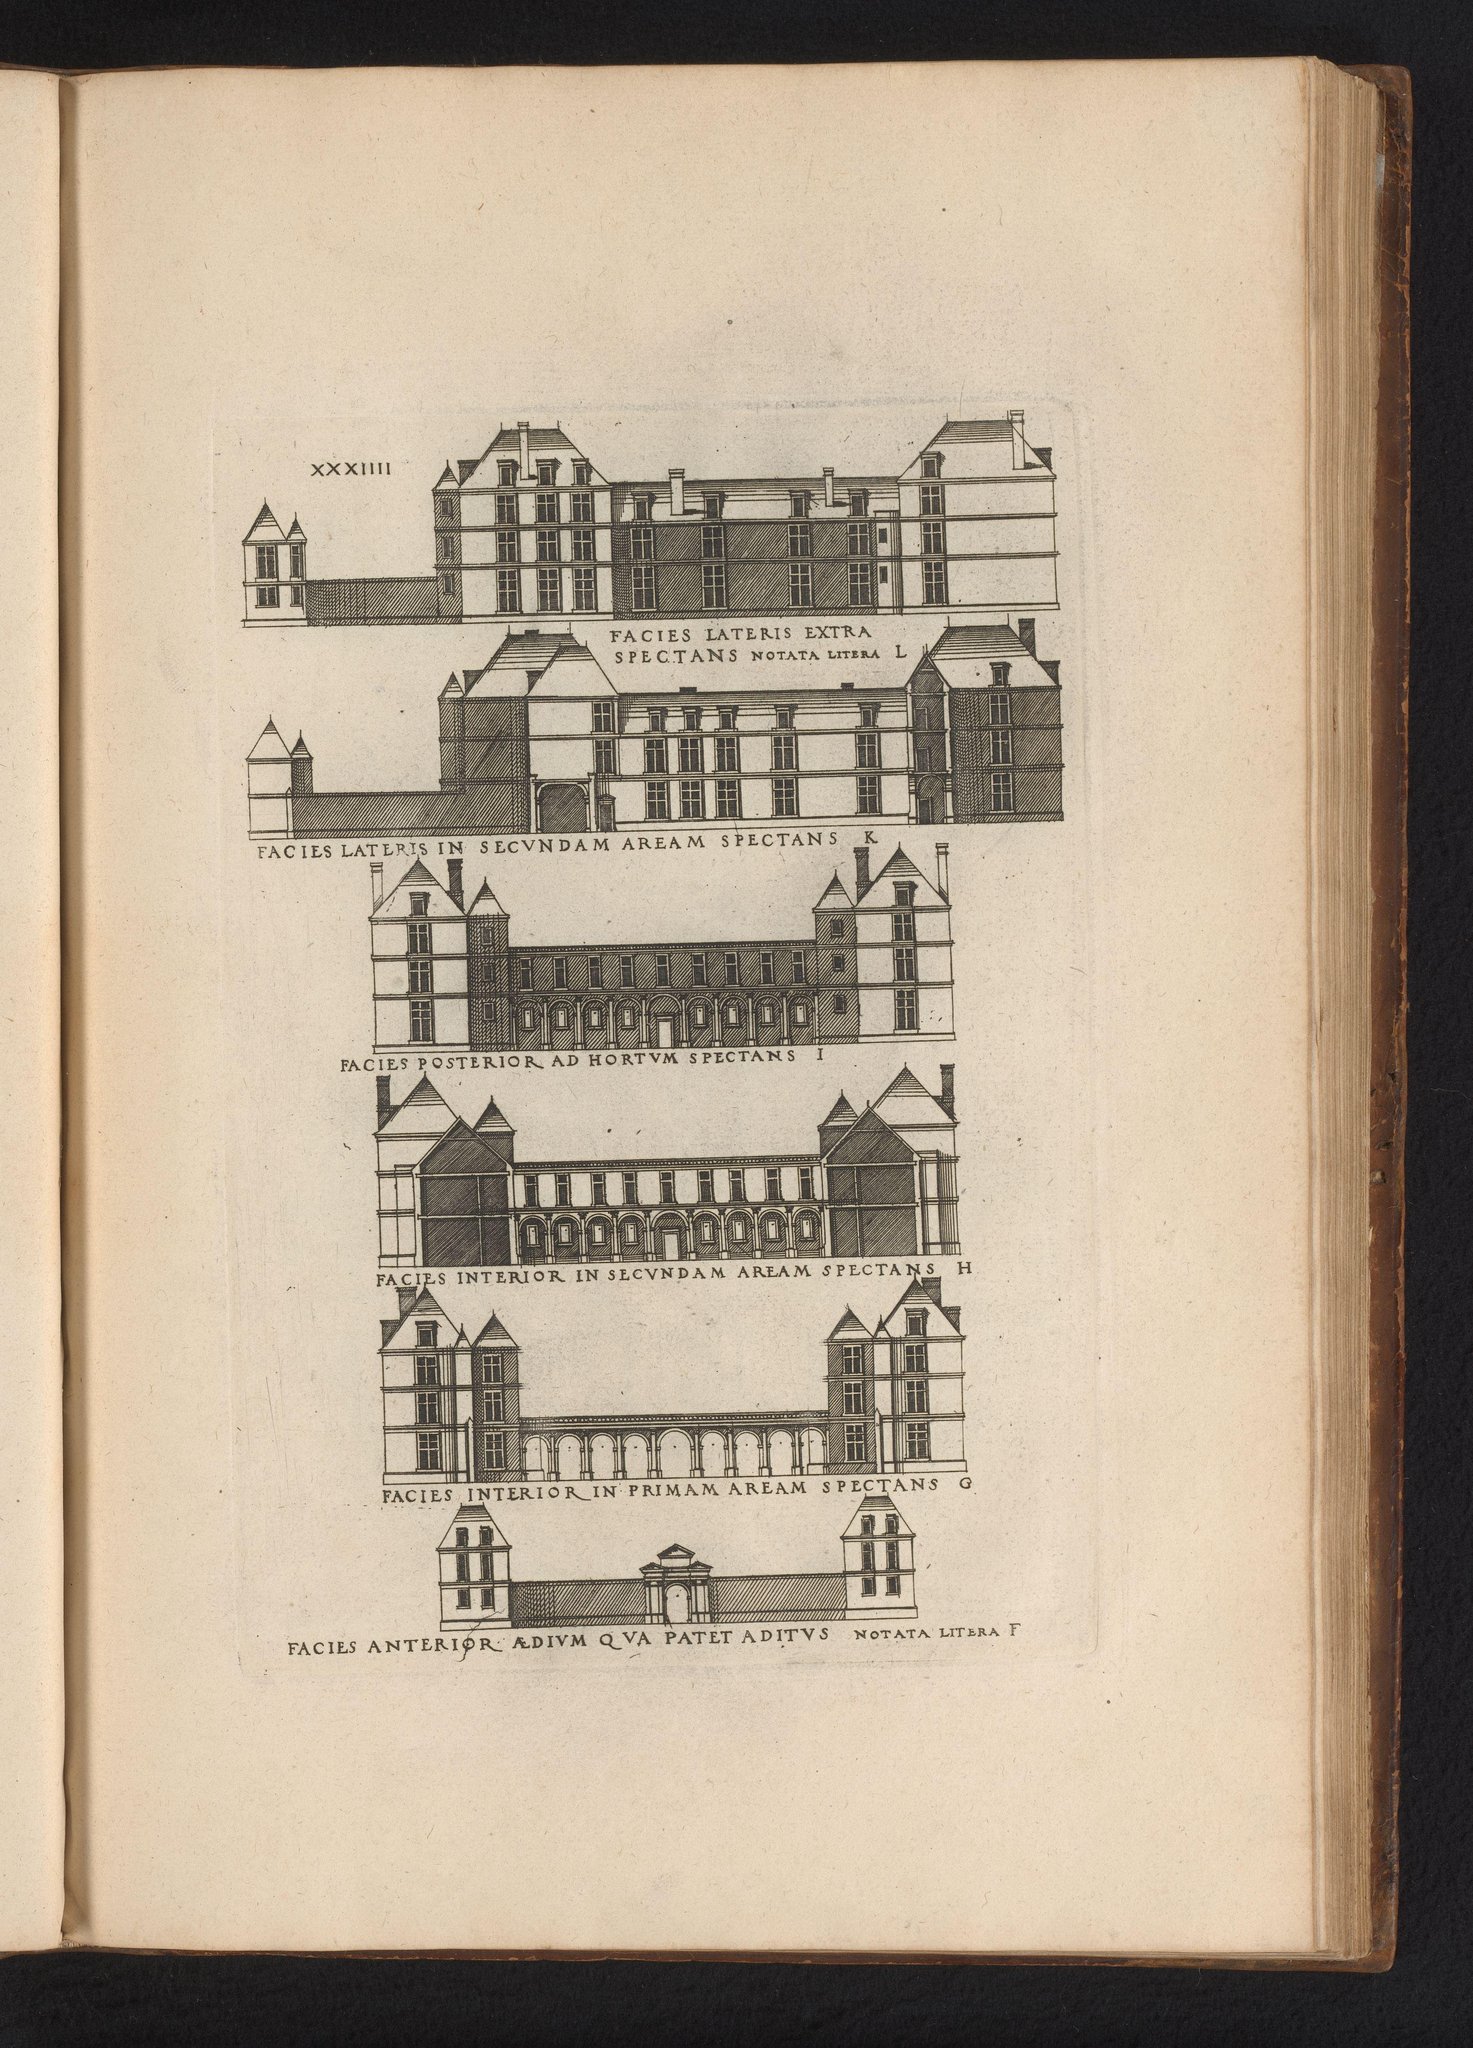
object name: ornament print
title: Aanzichten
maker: jacques androuet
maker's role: draughtsman, print maker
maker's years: 1515-1584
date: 1559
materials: paper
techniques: etching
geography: paris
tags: architectural design or model, façade (of house or building)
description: Zes aanzichten van architectuur. Genummerd: XXXIIII. Onderdeel van 'De architectura Iacobi Androuetii du Cerceau' (1559): 69 etsen met 171 voorstellingen van architectuur en ornamentiek.